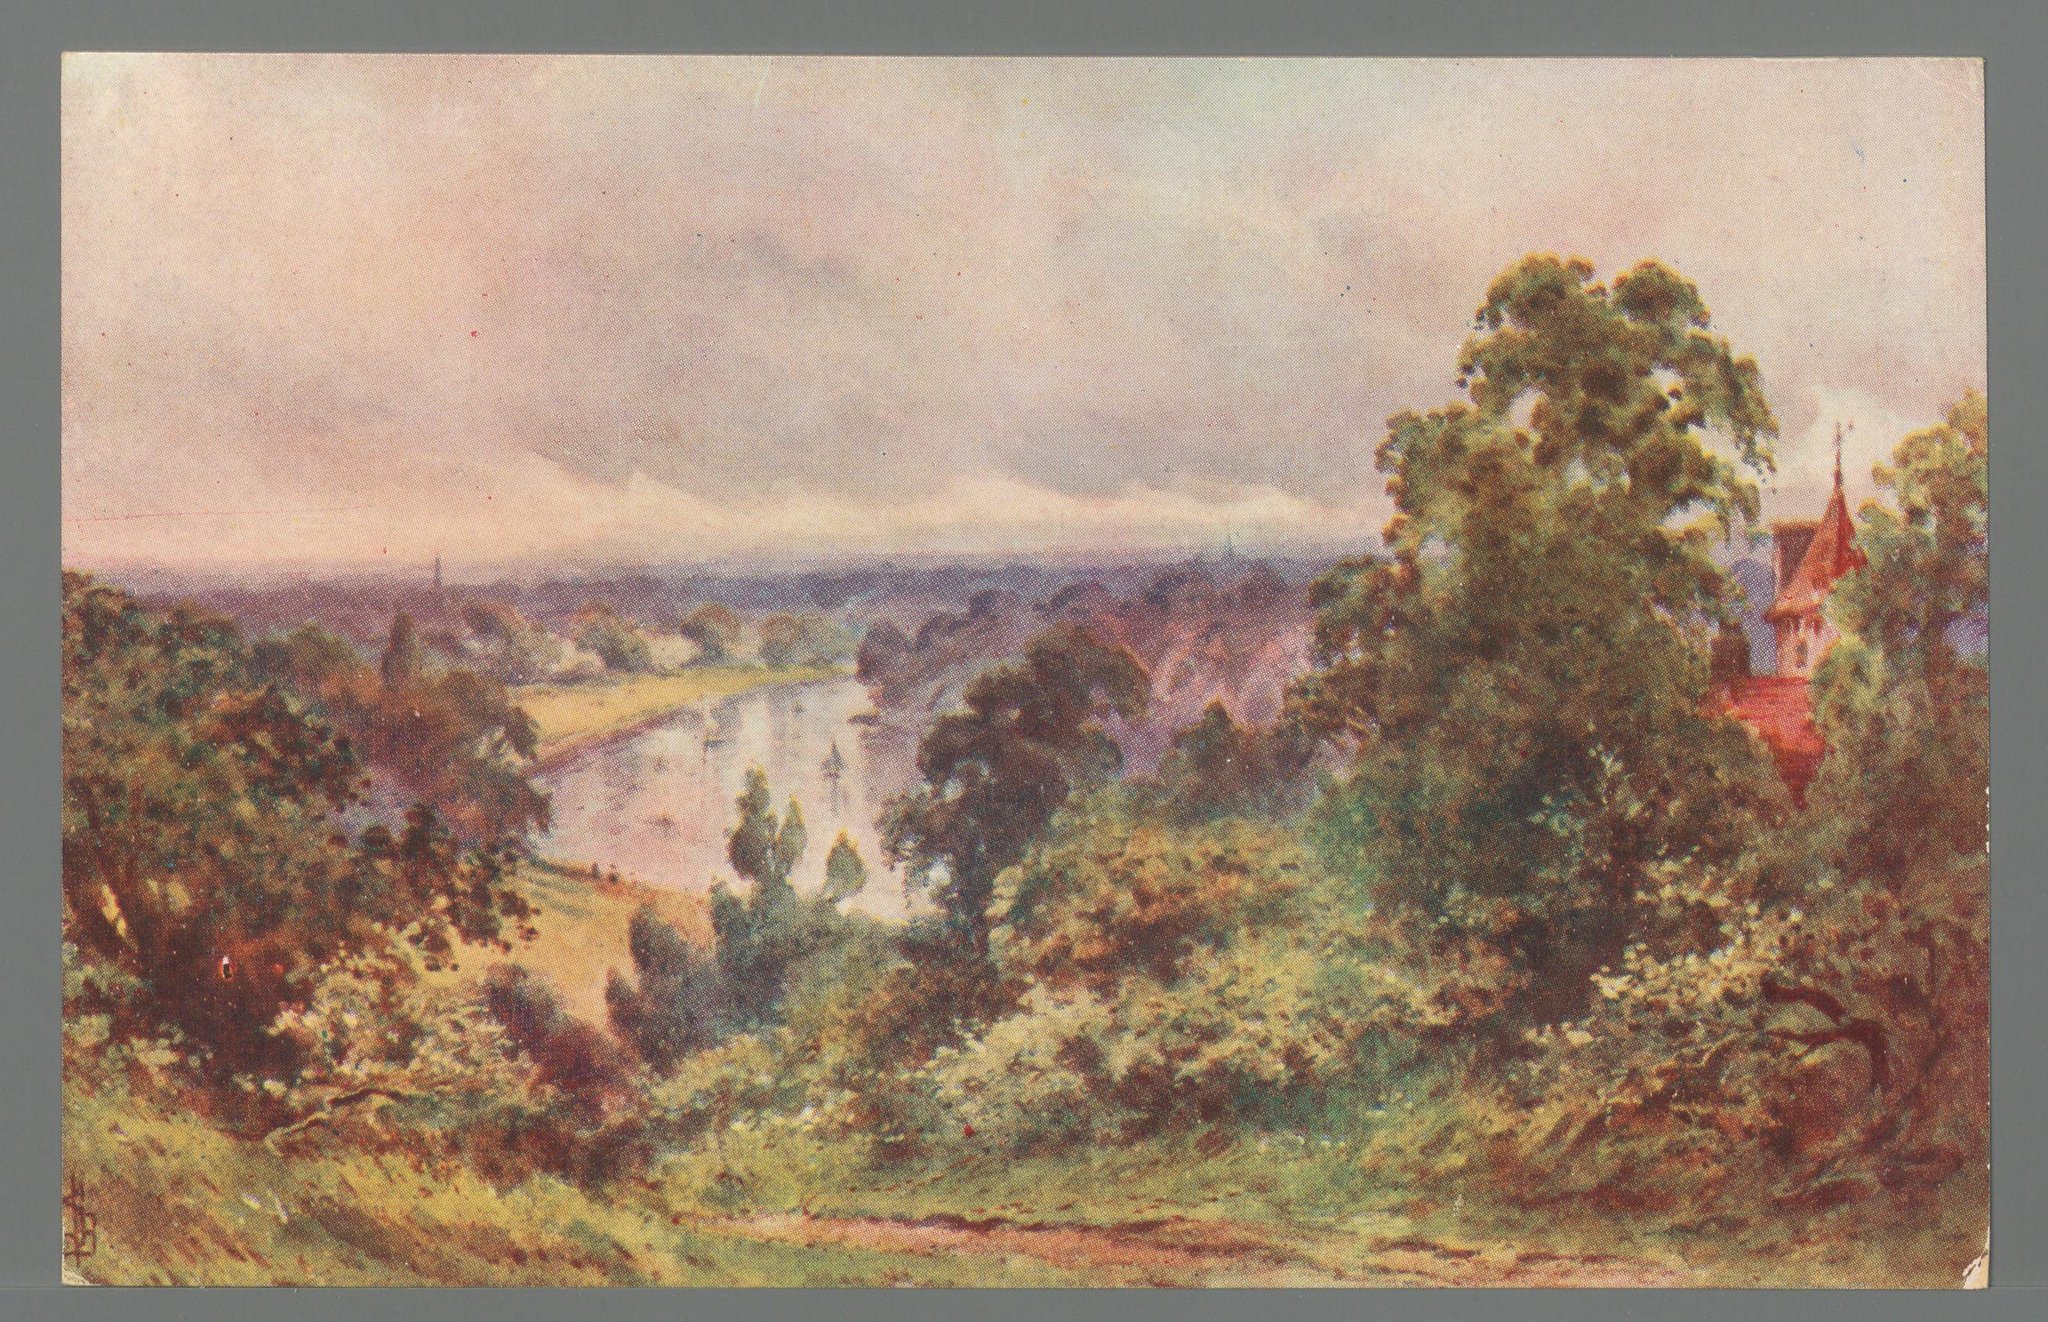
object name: photomechanical print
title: Richmond Hill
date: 1902-1930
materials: cardboard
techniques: color autotype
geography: richmond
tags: city-view, and landscape with man-made constructions, river, thames